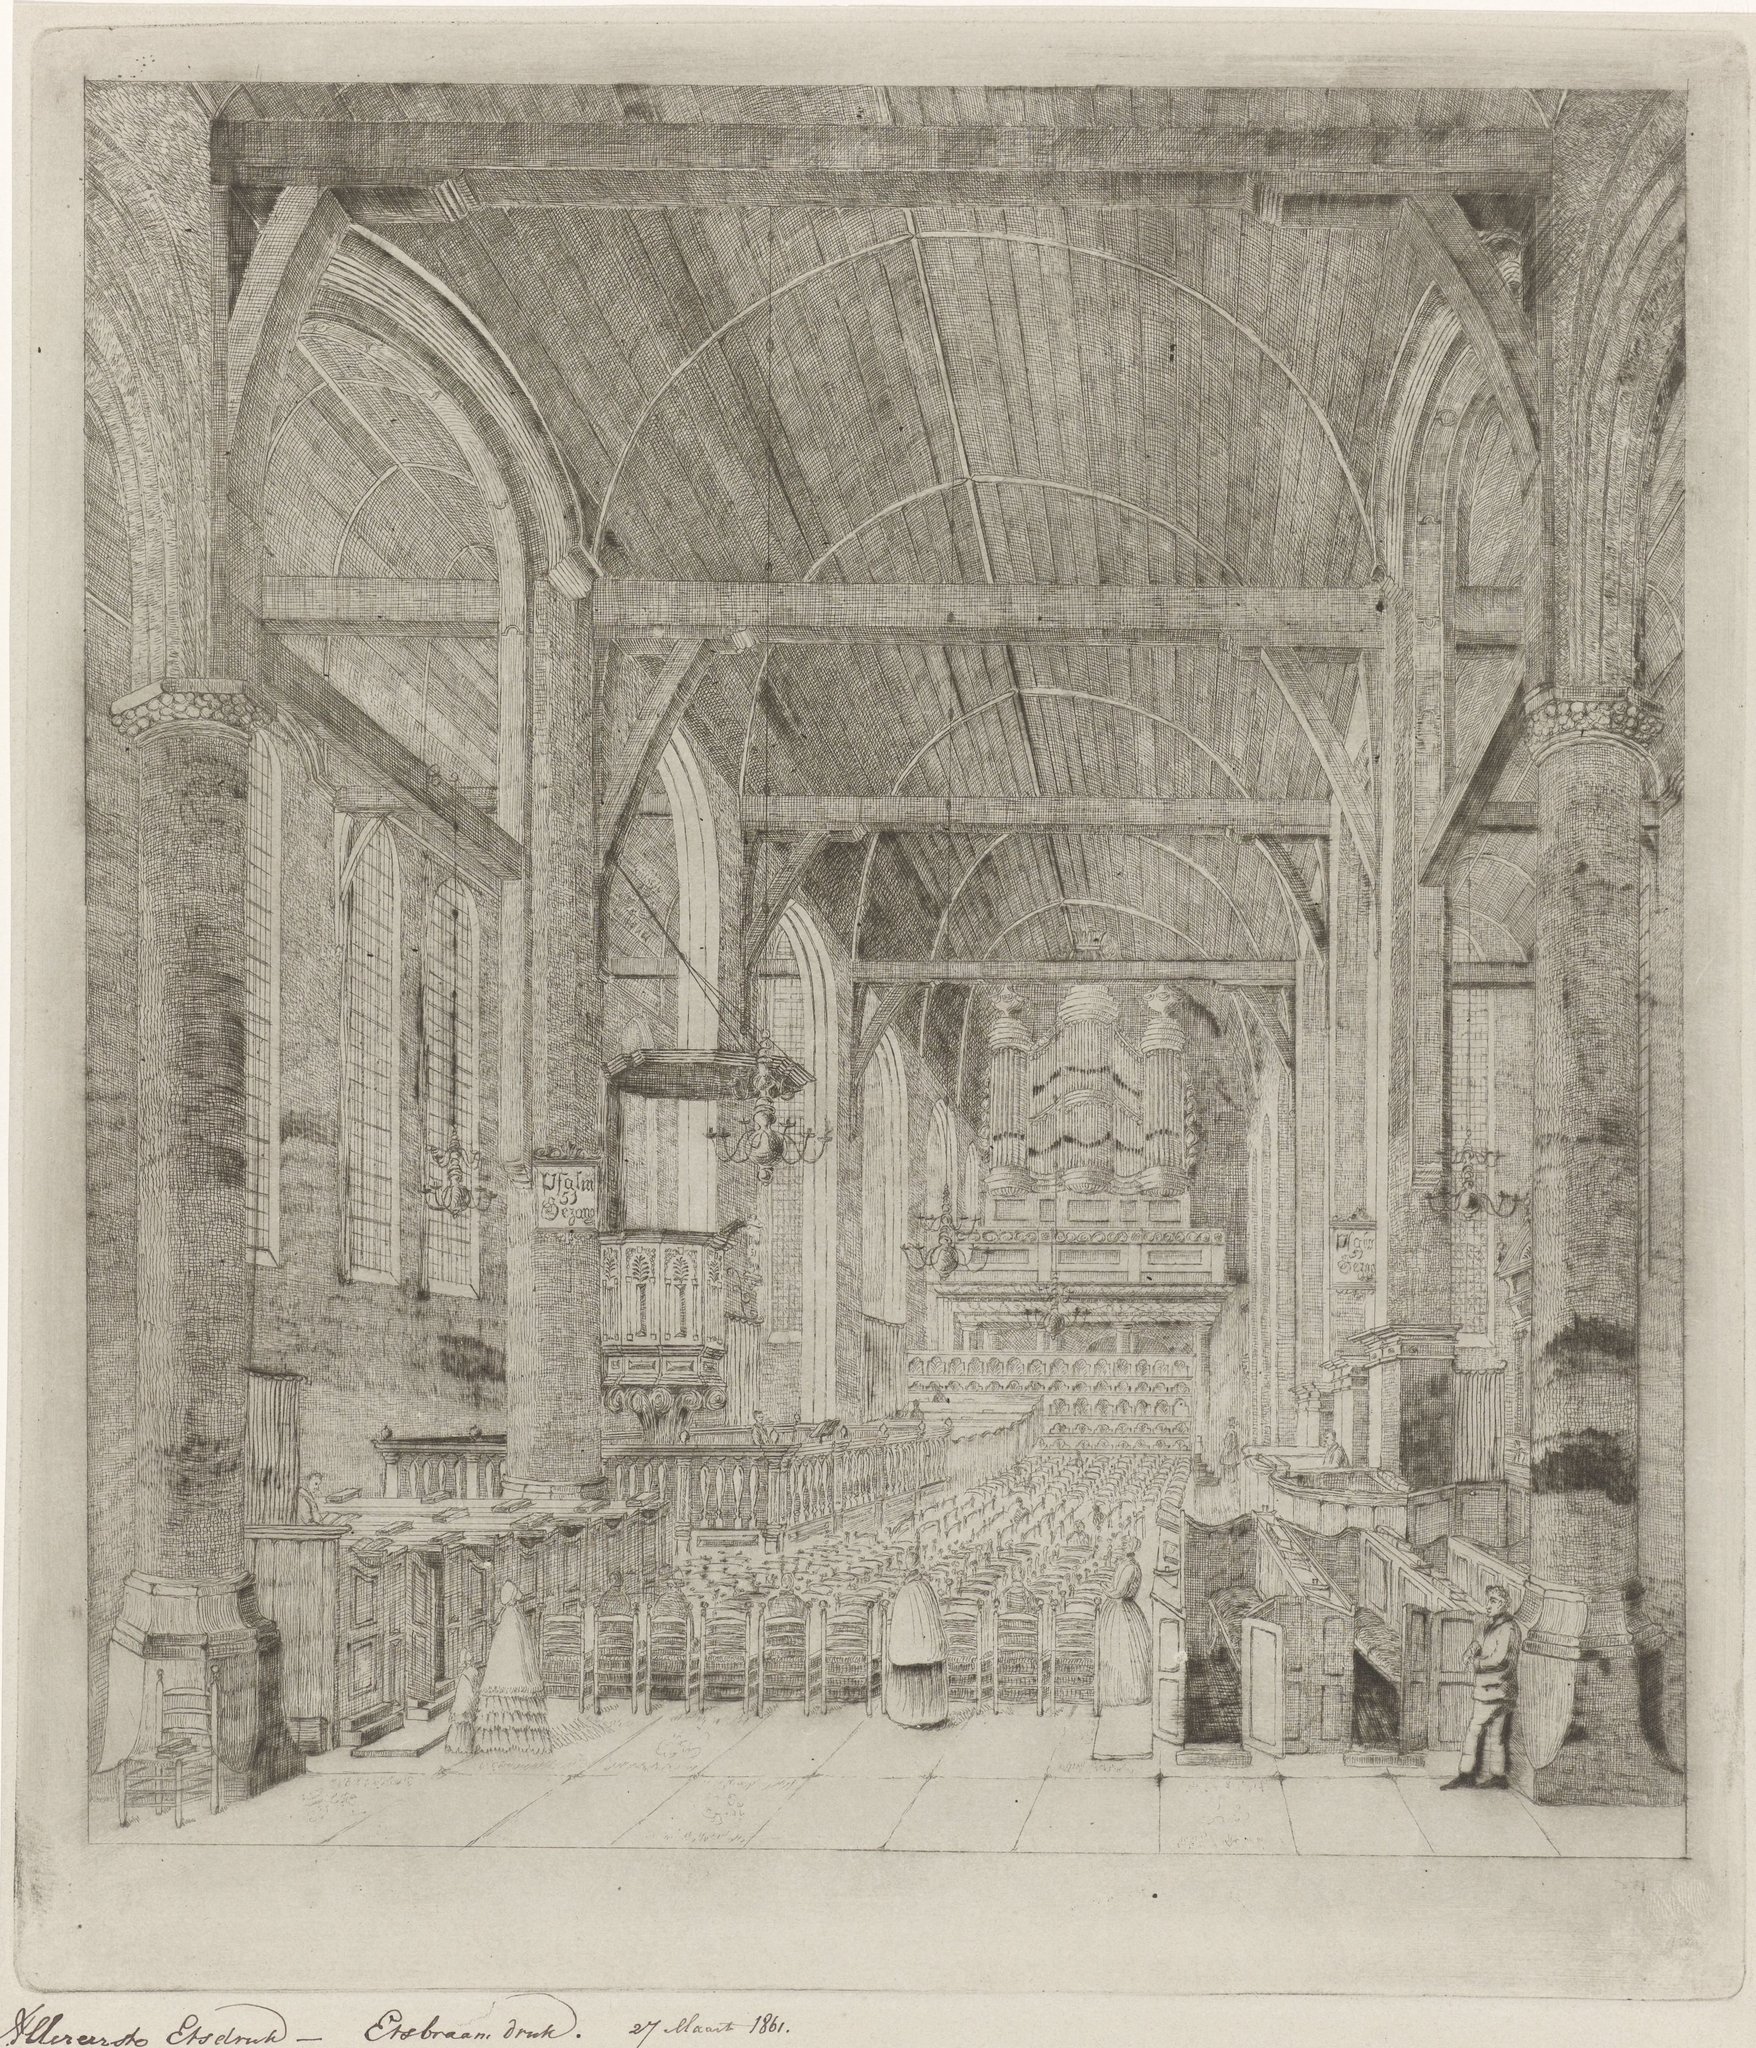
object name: print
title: Interieur van een kerk te Oudewater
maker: eberhard cornelis rahms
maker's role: print maker, publisher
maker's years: 1823-1907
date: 1861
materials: paper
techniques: drypoint, etching, intaglio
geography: oudewater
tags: interior of church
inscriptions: collector's mark: Lugt 2228, inscription: ‘N 14 Koper [...] / De schets na de natuur genomen voor de reparatie anno 1857 [...] 27 Maart 1861’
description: Het interieur van een kerk te Oudewater, met links de predikstoel en op de achtergrond het orgel. Op de voorgrond enkele figuren.